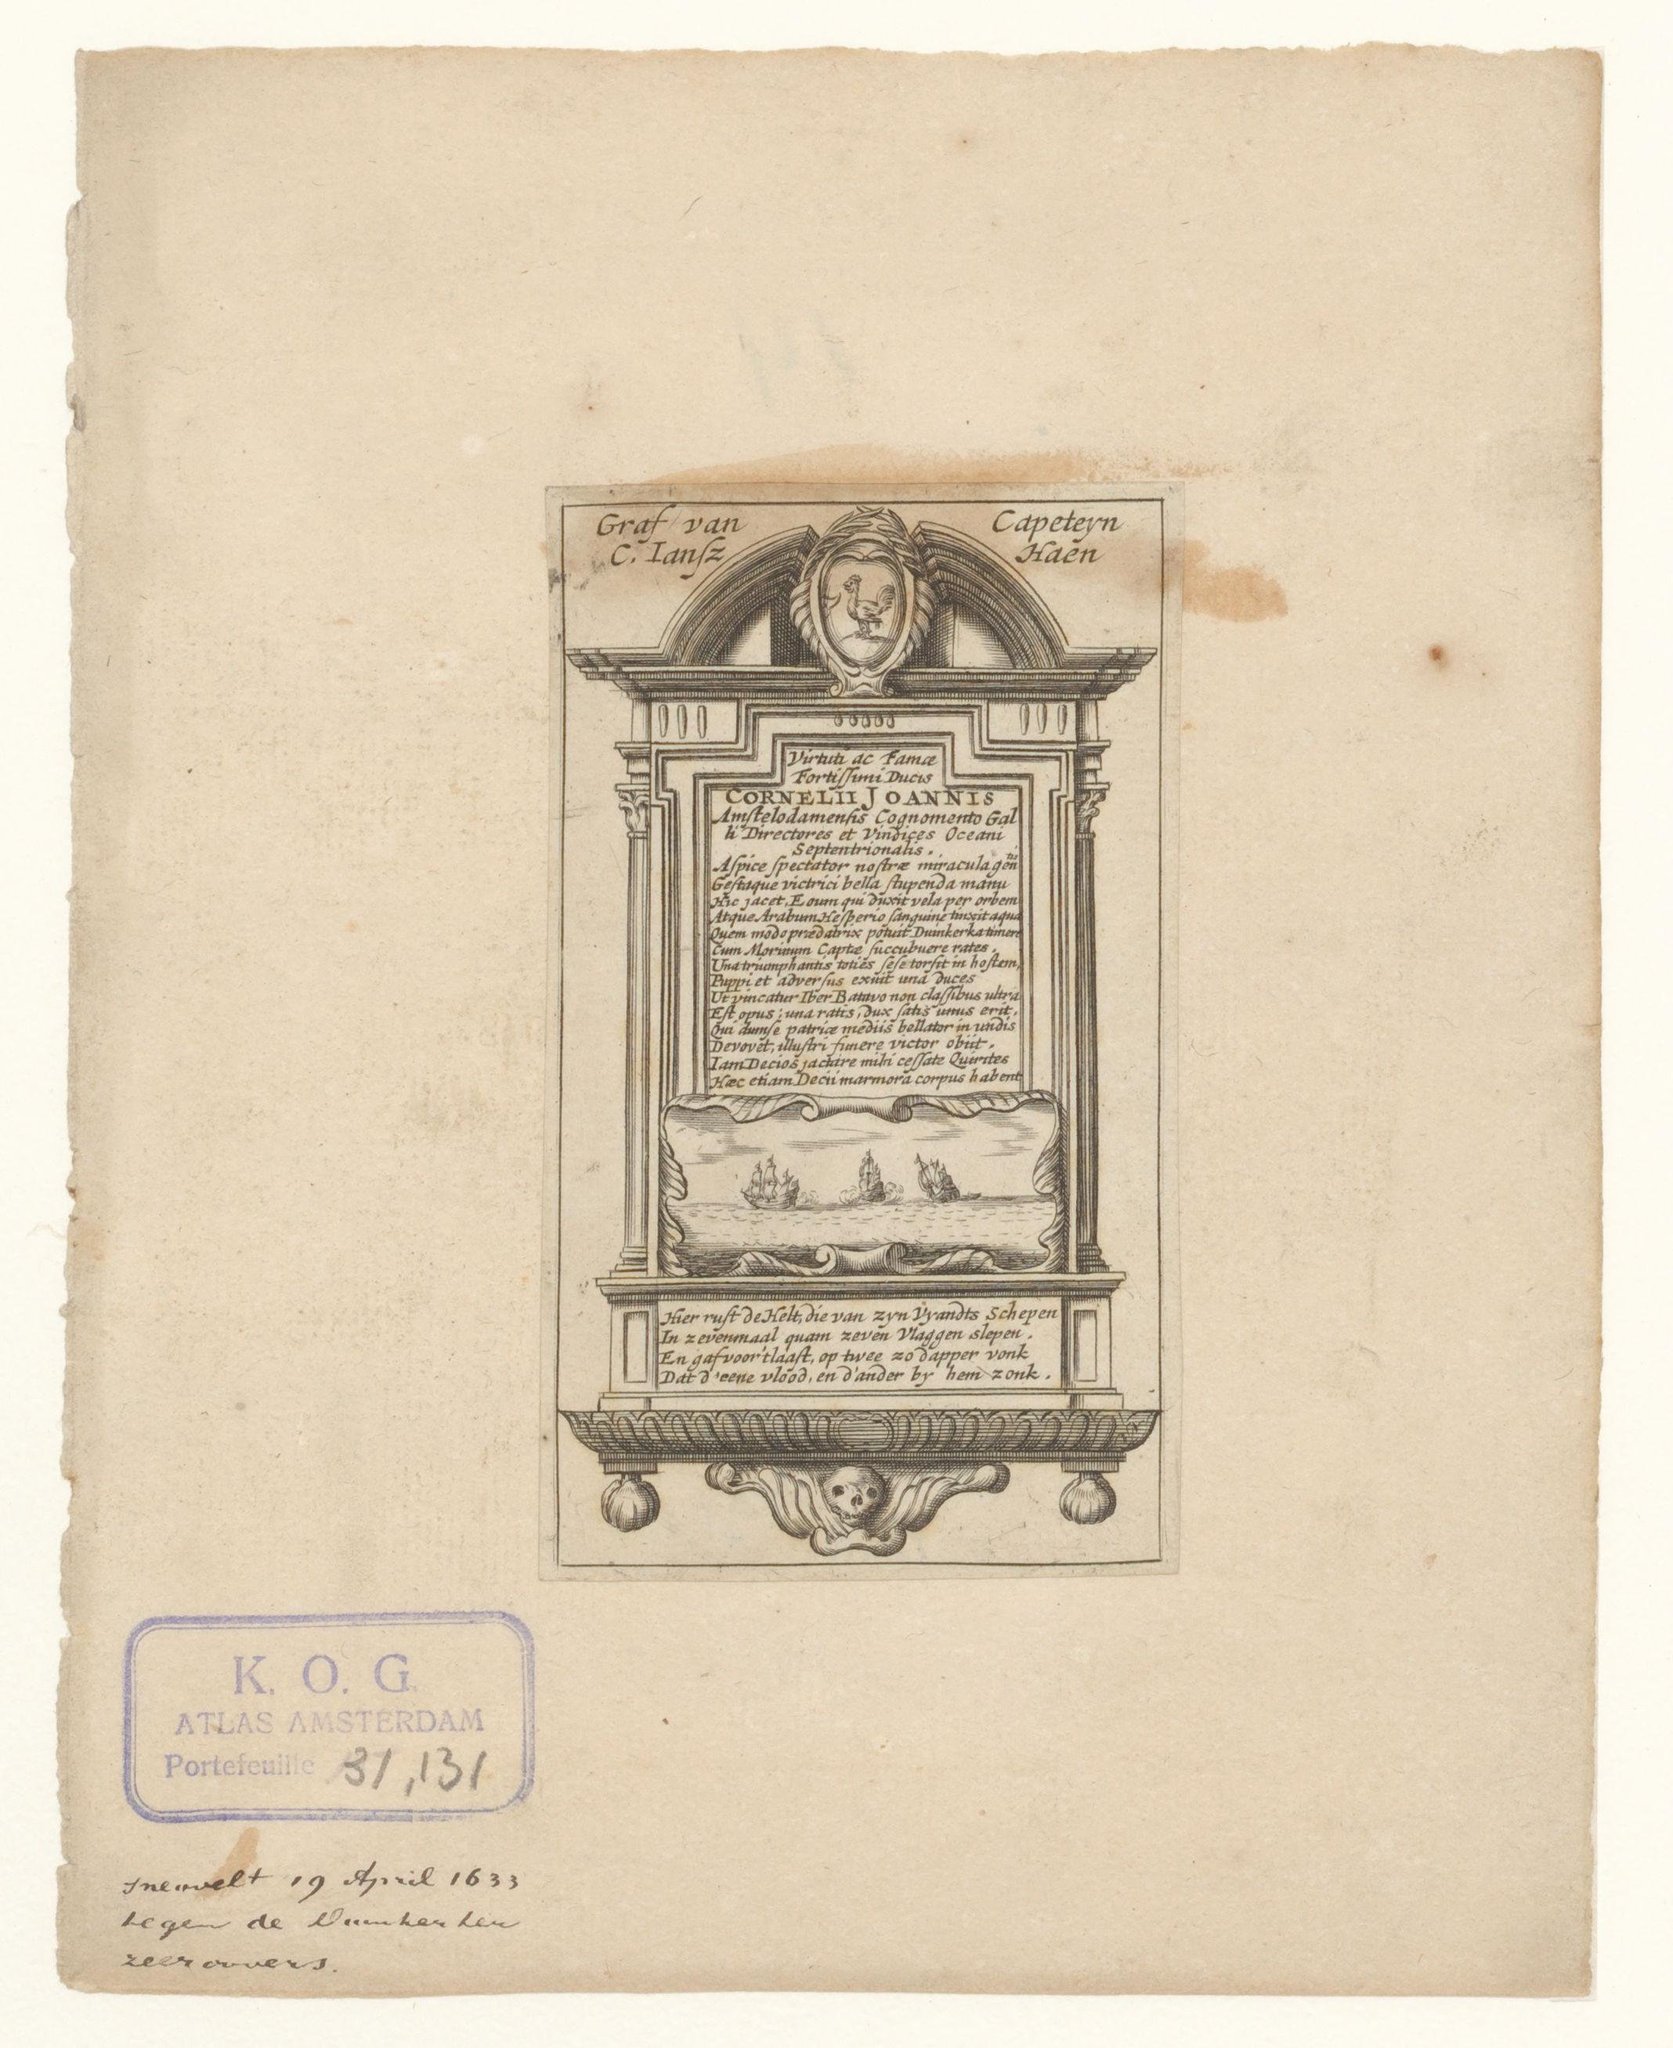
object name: book illustration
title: Graftombe van kapitein Cornelis Jansz de Haen, 1633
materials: ink, paper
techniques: engraving, letterpress printing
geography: northern netherlands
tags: grave-building, monumental tomb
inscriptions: inscription: ‘sneuvelt 19 April 1633 tegen de Duinkerker zeeroovers’, collector's mark: ‘31.131’ Lugt 1641b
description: Prent uit: Commelin, Caspar. Beschryvinge van Amsterdam, zynde een naukeurige verhandelinge van desselfs eerste oorspronk uyt (…). Amsterdam: weduwe Aart Dircksz Oossaan, 1694, p. 433.